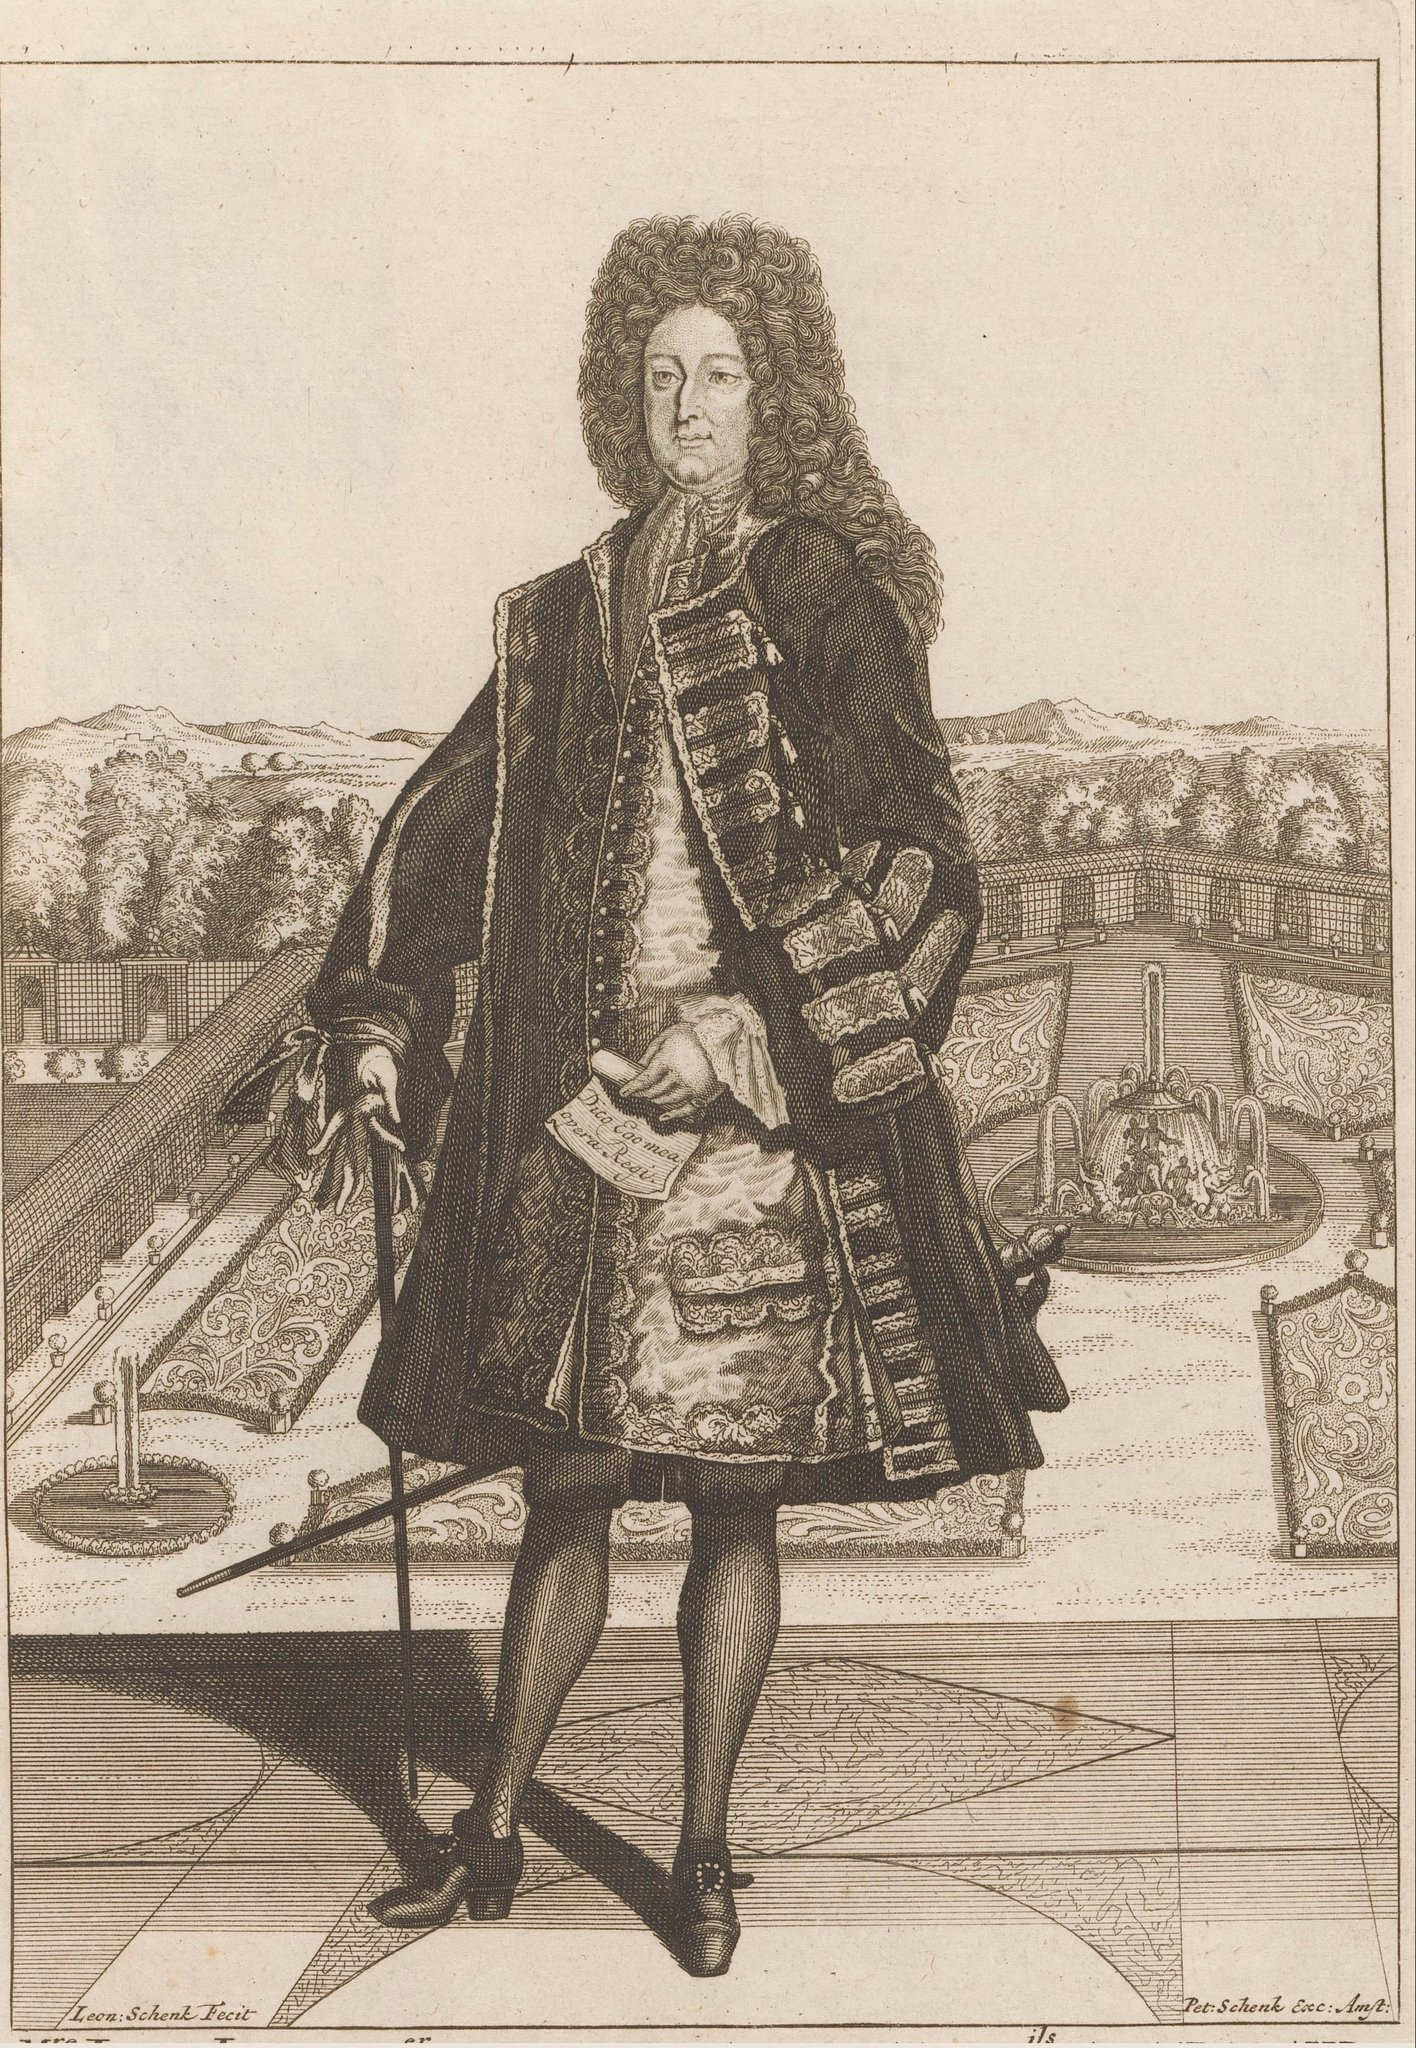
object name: print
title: Mre. Jean Law con.er du roy en tous ces con.ils controleur gnal des finances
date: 1720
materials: paper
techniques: etching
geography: amsterdam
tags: econoom, john law, windhandel van 1720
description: Portret van John Law, staande ten voeten uit, op de achtergrond een tuin met fontein. In het onderschrift een vierregelig vers in het Frans. Blad in de gebonden eerste uitgave (304 B 10) van Het Groote Tafereel der Dwaasheid met spotprenten op de Windhandel of Actiehandel van 1720.